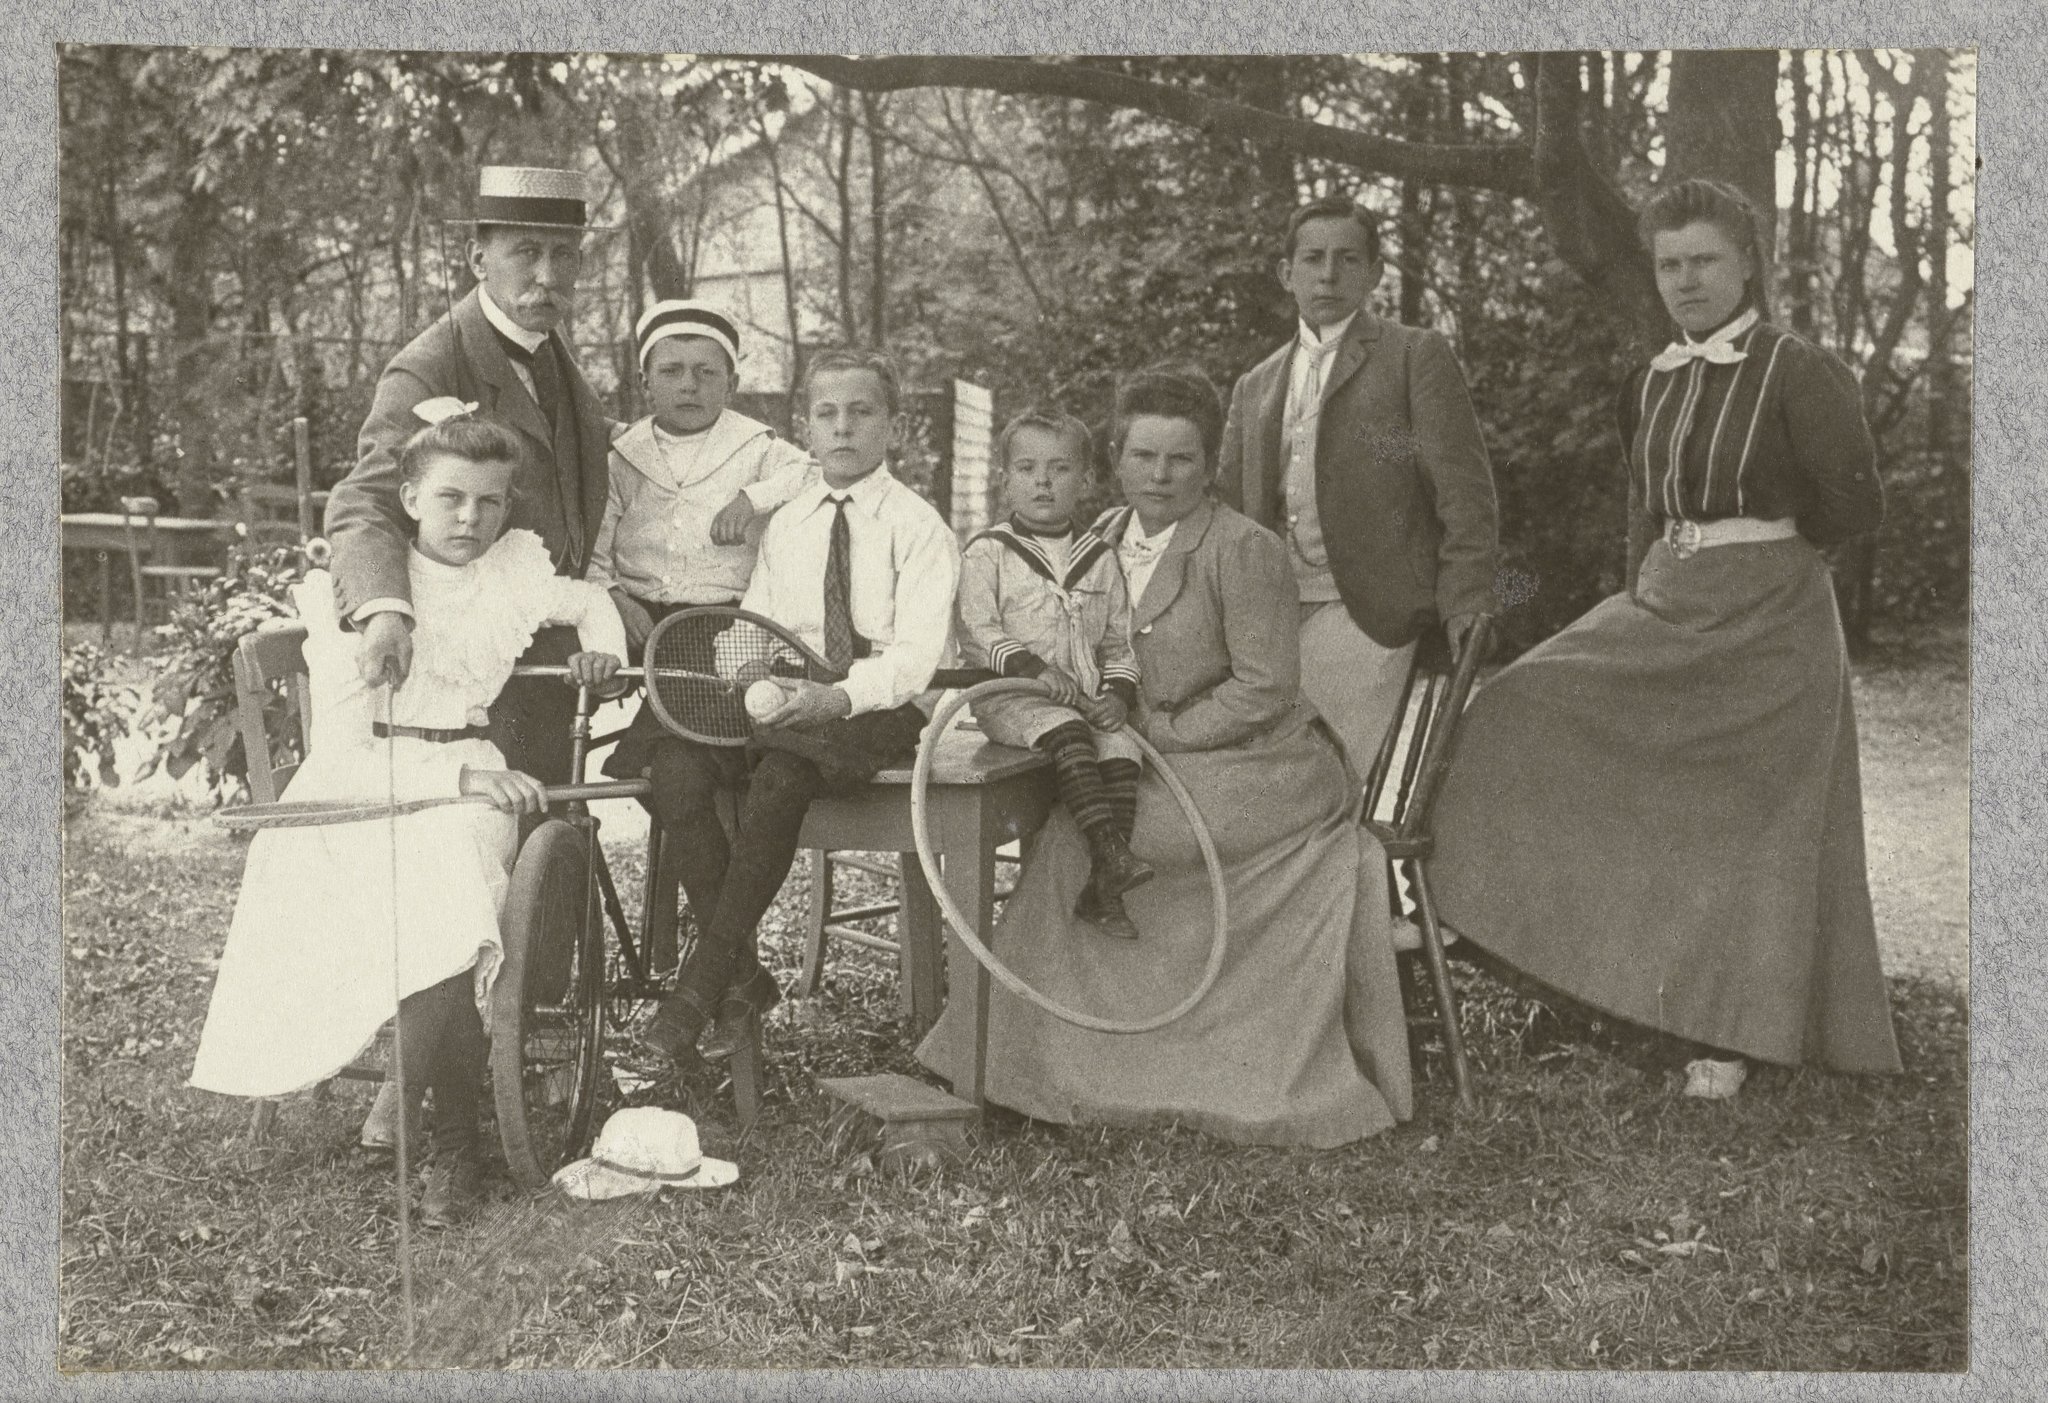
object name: photograph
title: Familieportret van de Kesslers in de tuin, J.B. Aug Kessler bedient de zelfontspanner (zelfportret)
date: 1897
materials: paper, photographic support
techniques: gelatin silver print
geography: netherlands